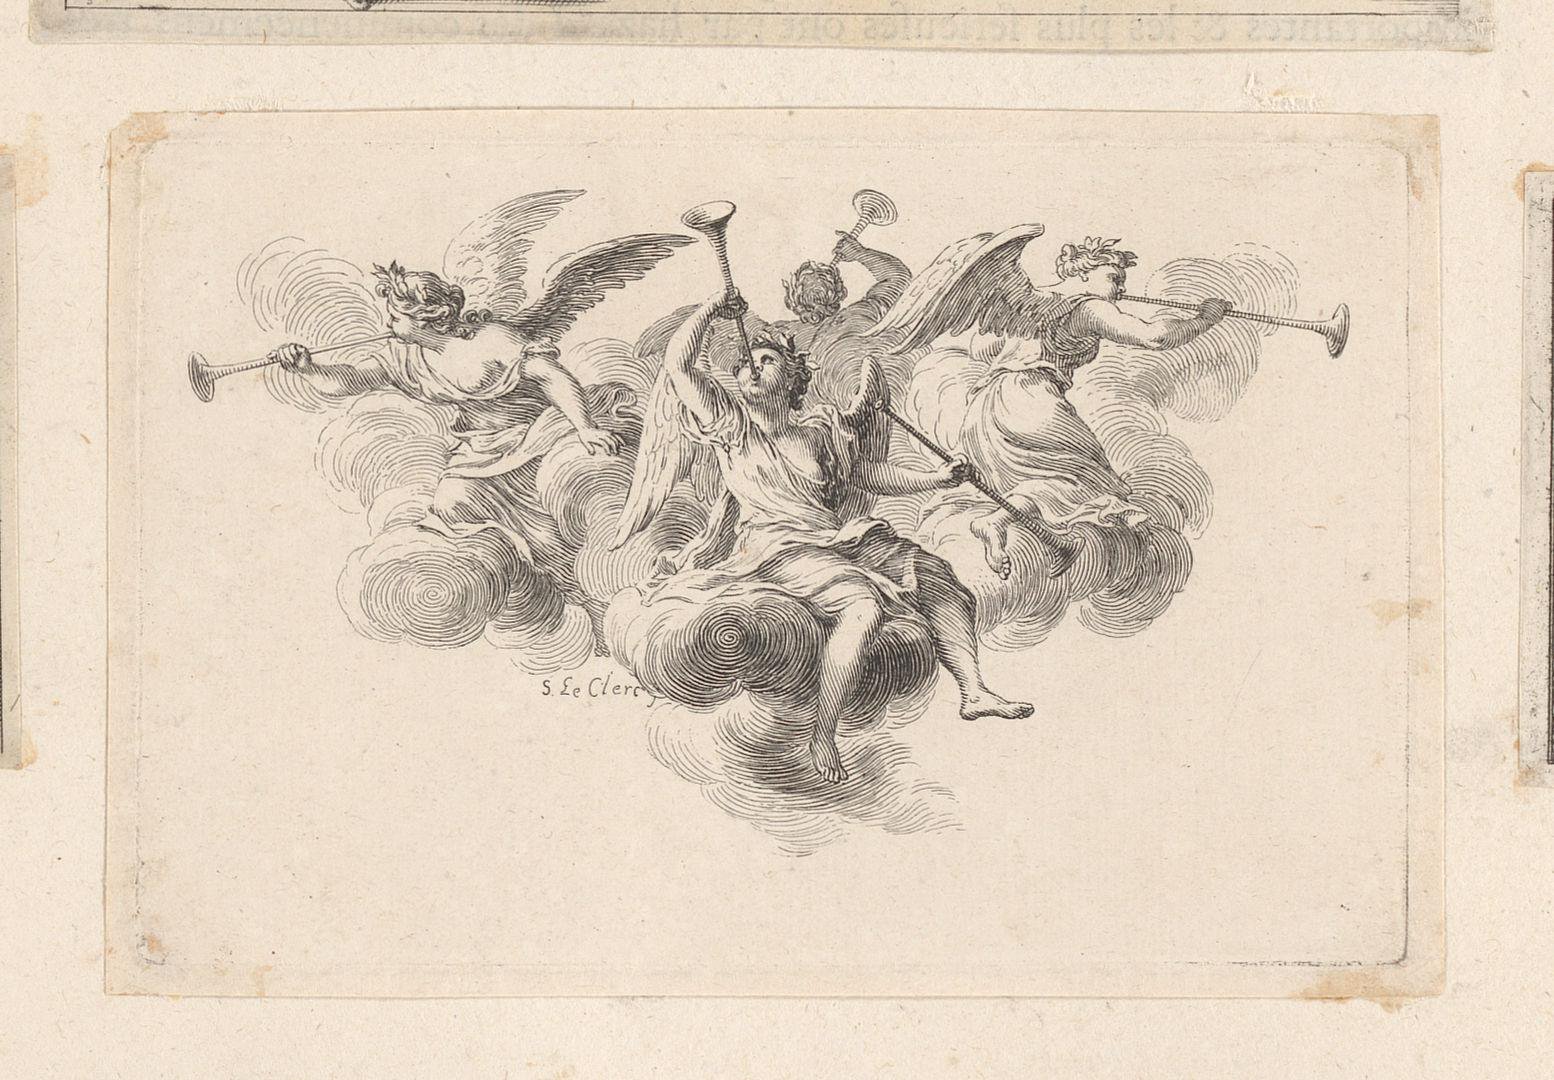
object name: album leaf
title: Cul-de-lampe met blazoen blazende engelen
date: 1696-1700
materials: paper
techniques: etching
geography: paris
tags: vignette, angels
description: Prent uit: Perrault, Charles. Les Hommes illustres qui ont paru en France pendant ce siecle (...). Parijs: Antoine Dezallier, 1696-1700.